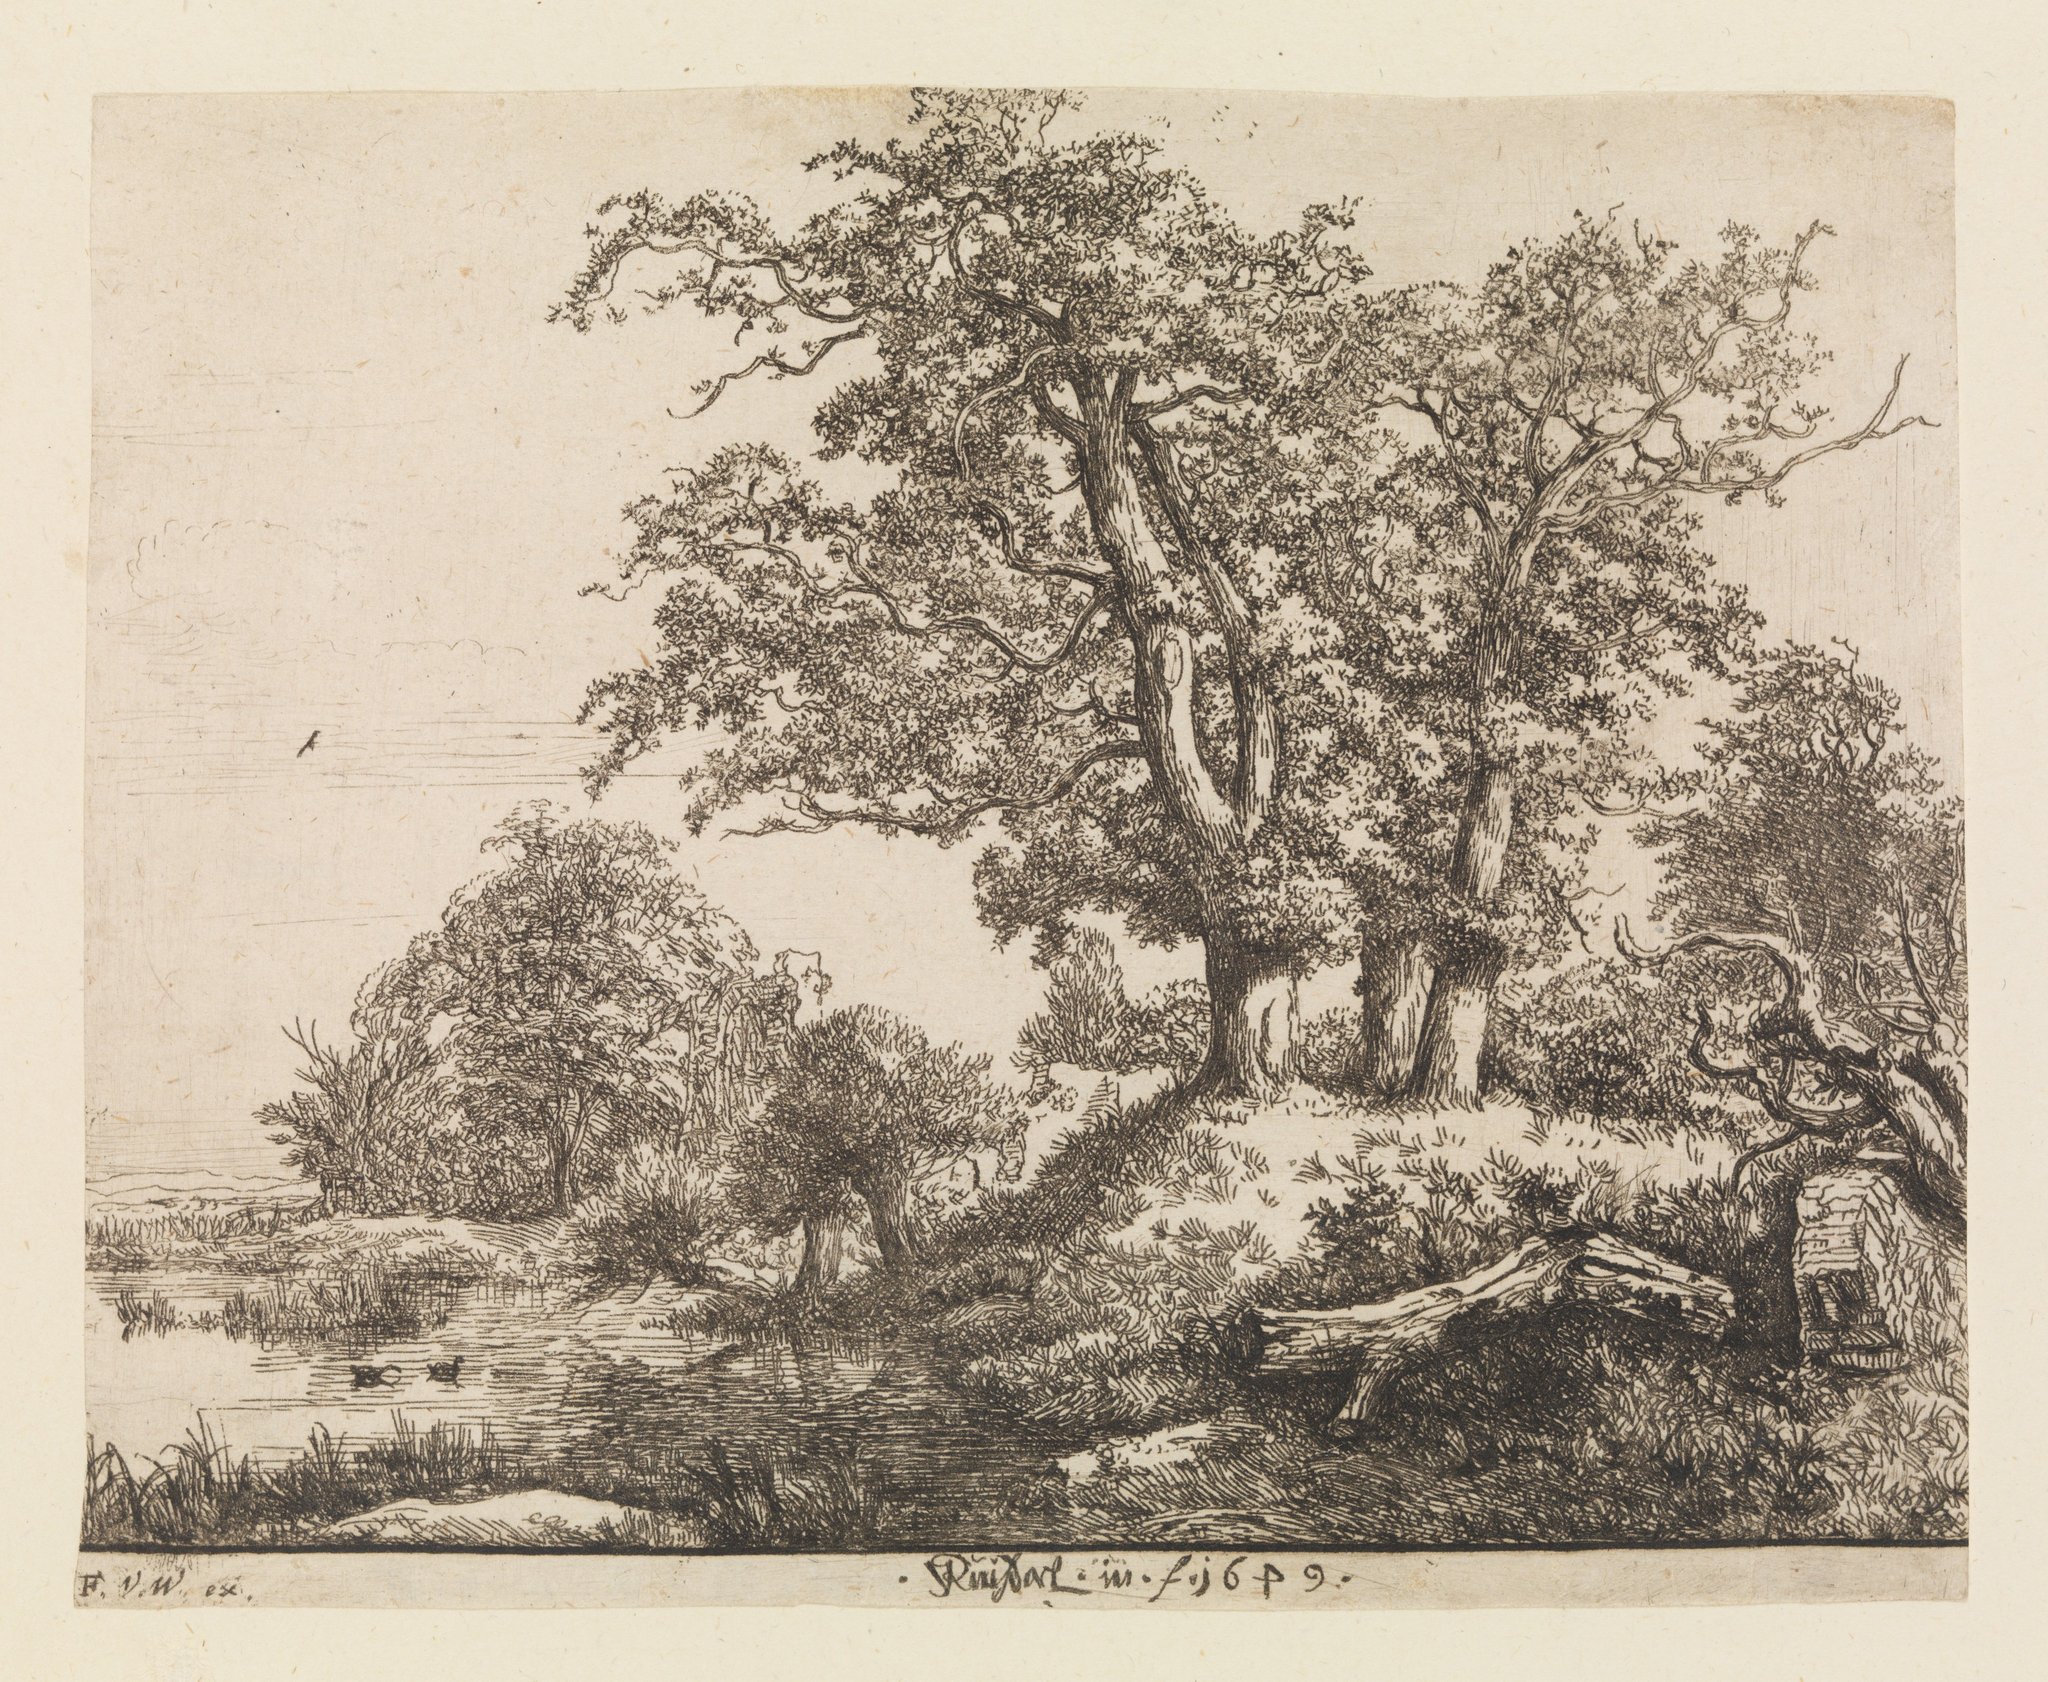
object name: print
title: The Three Oaks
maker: jacob isaacksz van ruisdael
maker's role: artist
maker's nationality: dutch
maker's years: 1628-1682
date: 1634-1666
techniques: etching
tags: oaks